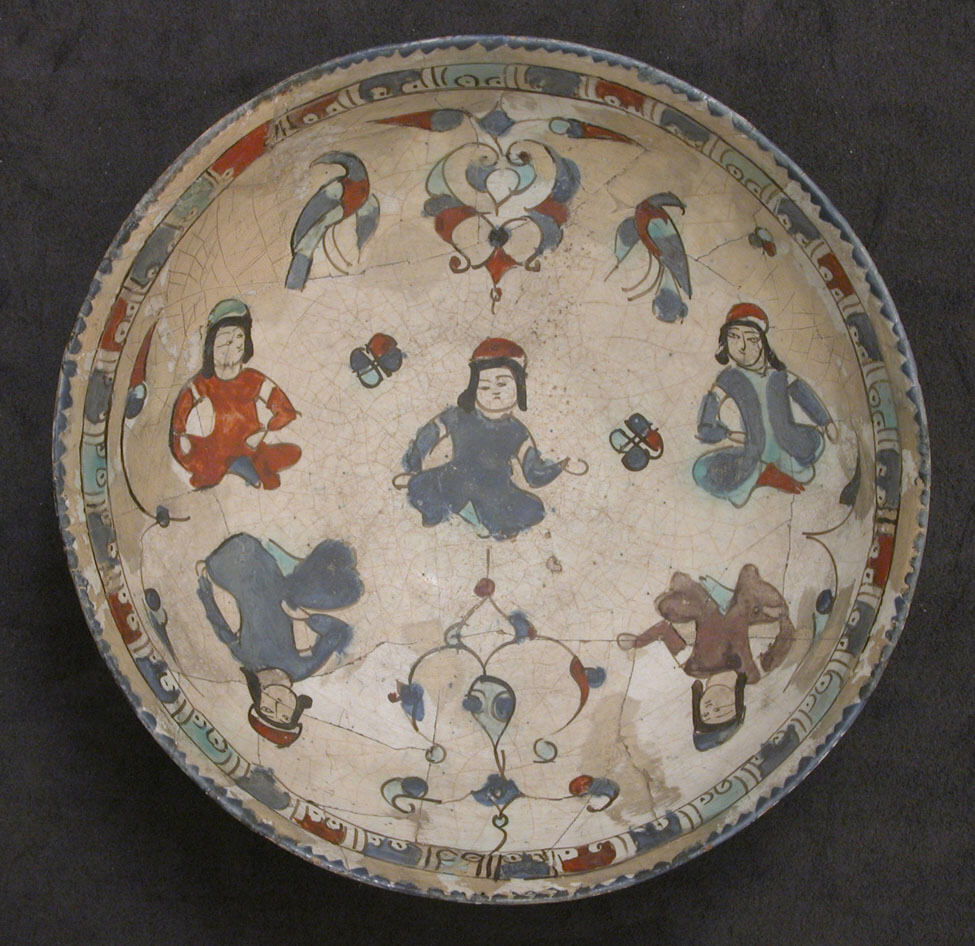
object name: bowl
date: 1101-1300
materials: stonepaste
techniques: overglaze, painting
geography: iran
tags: birds,men